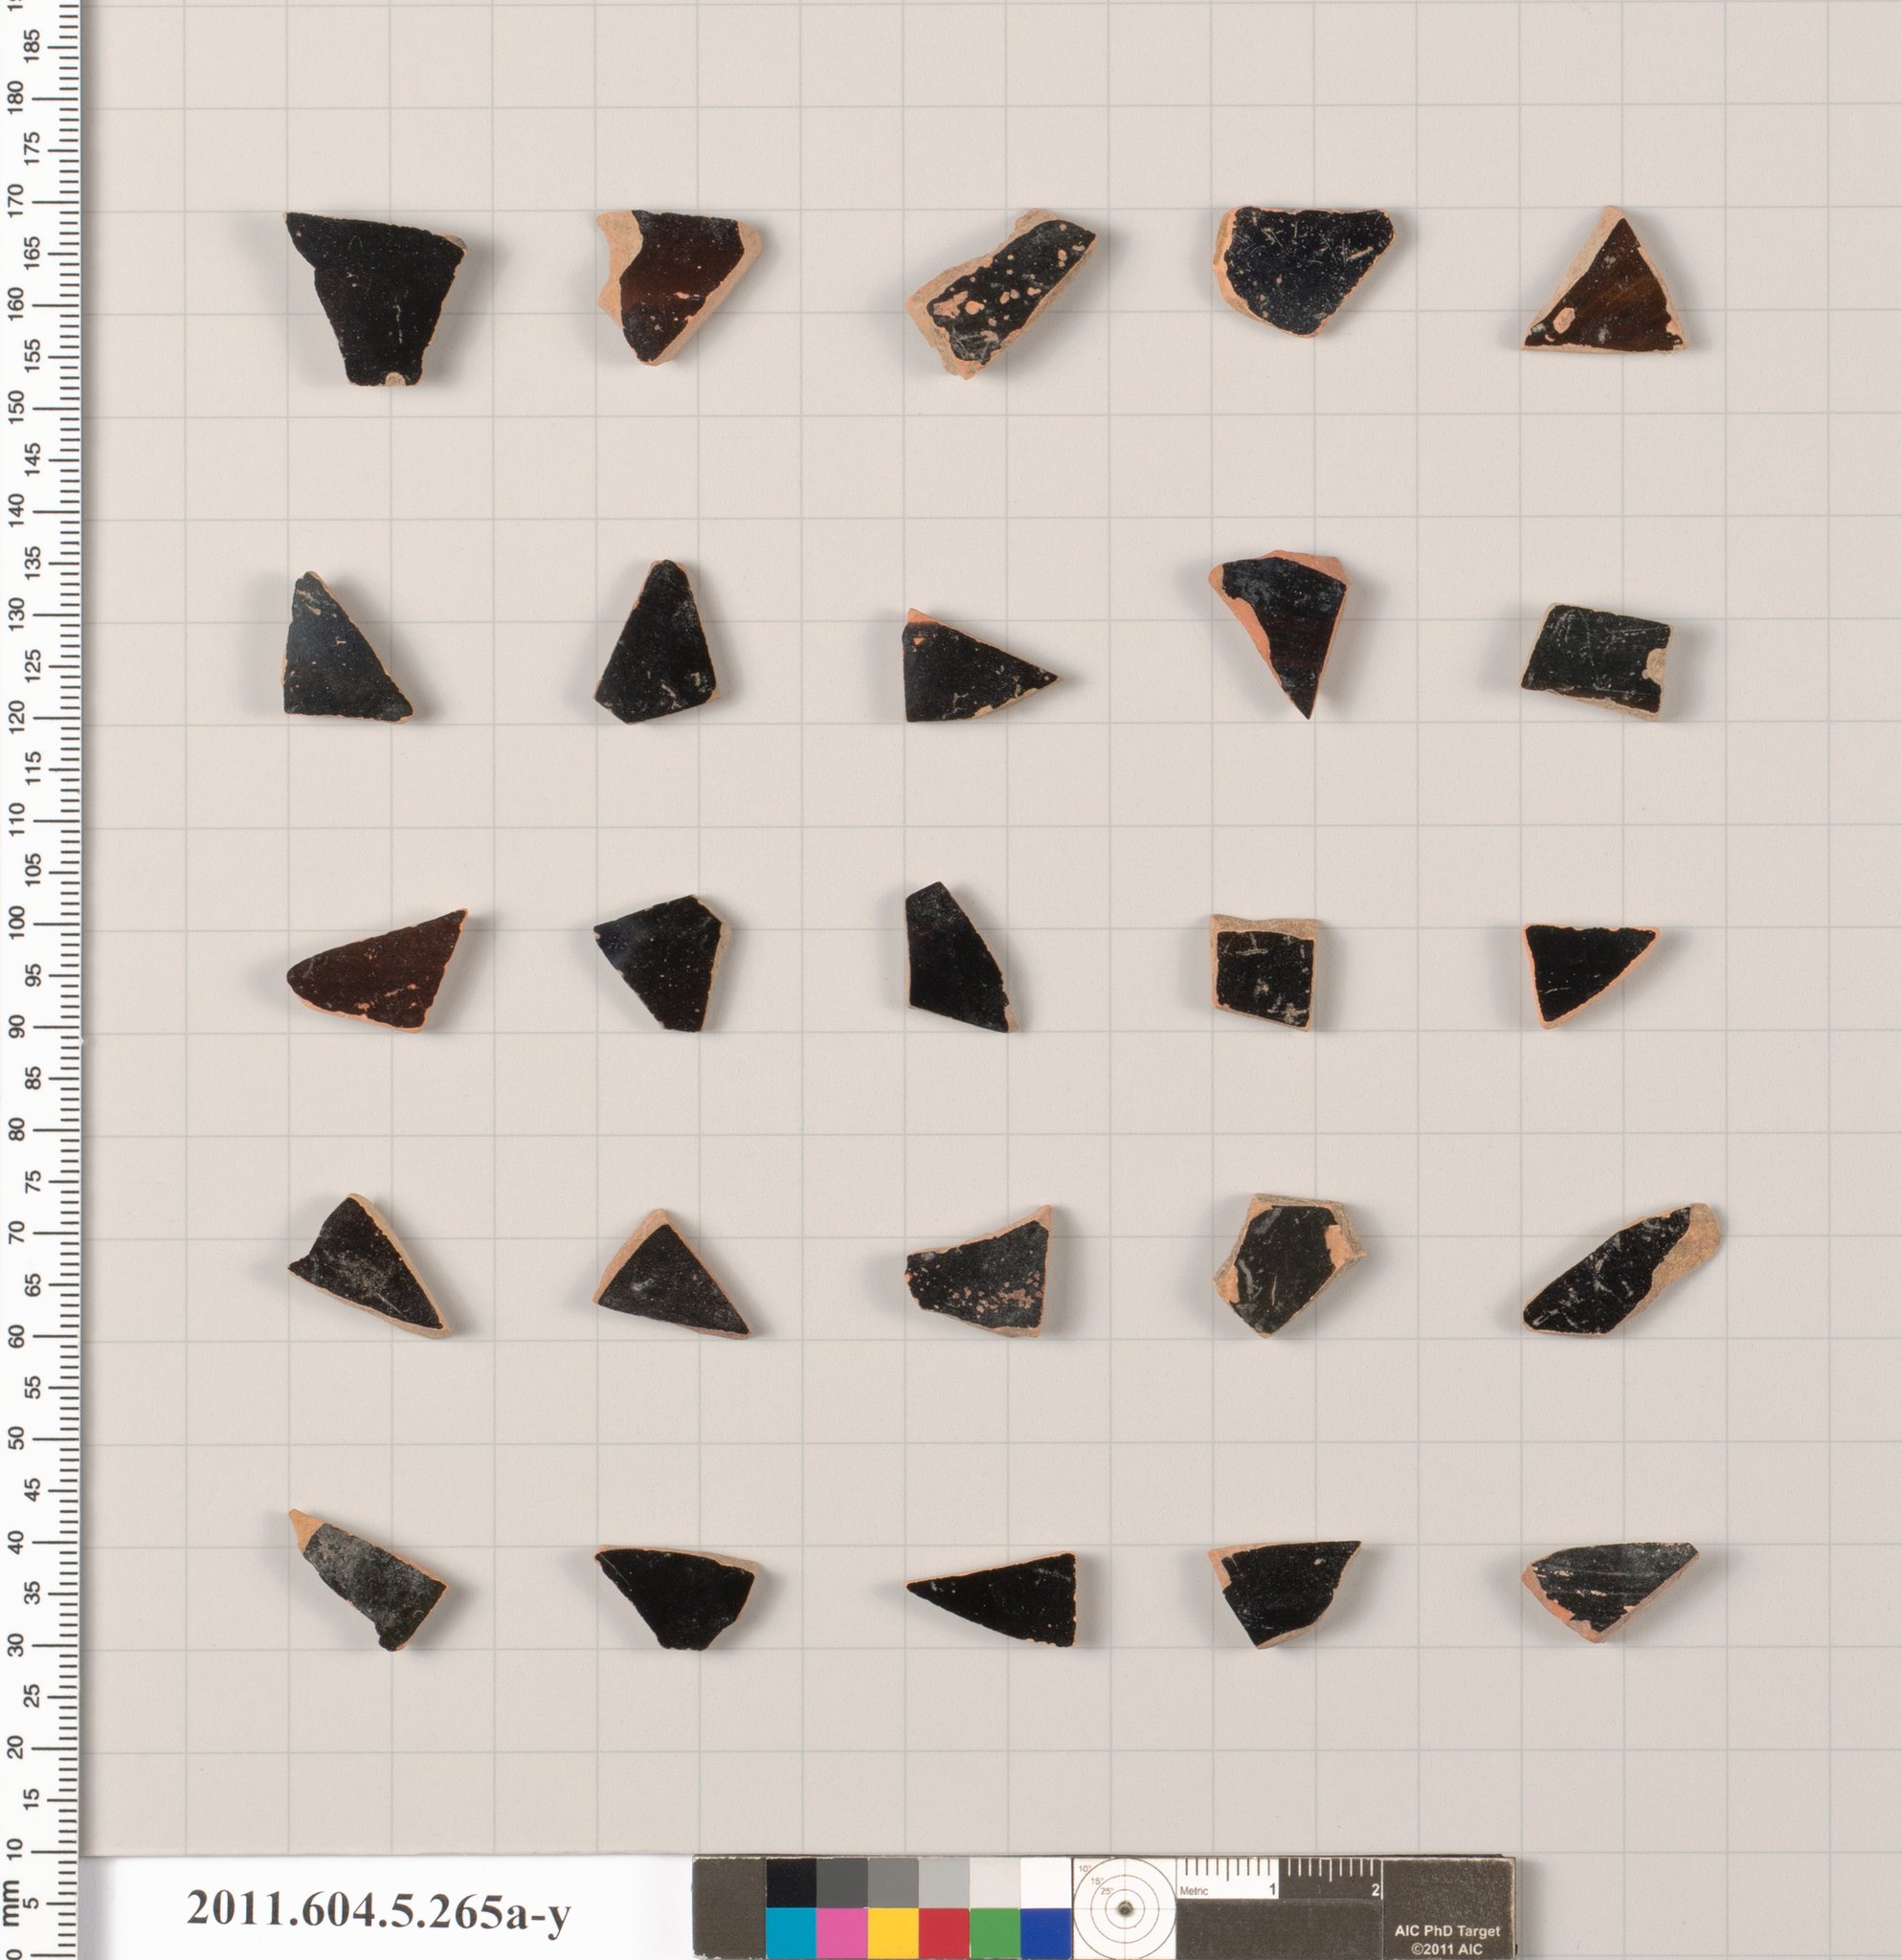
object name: kylix fragment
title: Terracotta fragments of kylikes (drinking cups)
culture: greek, attic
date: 600-401 BCE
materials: terracotta